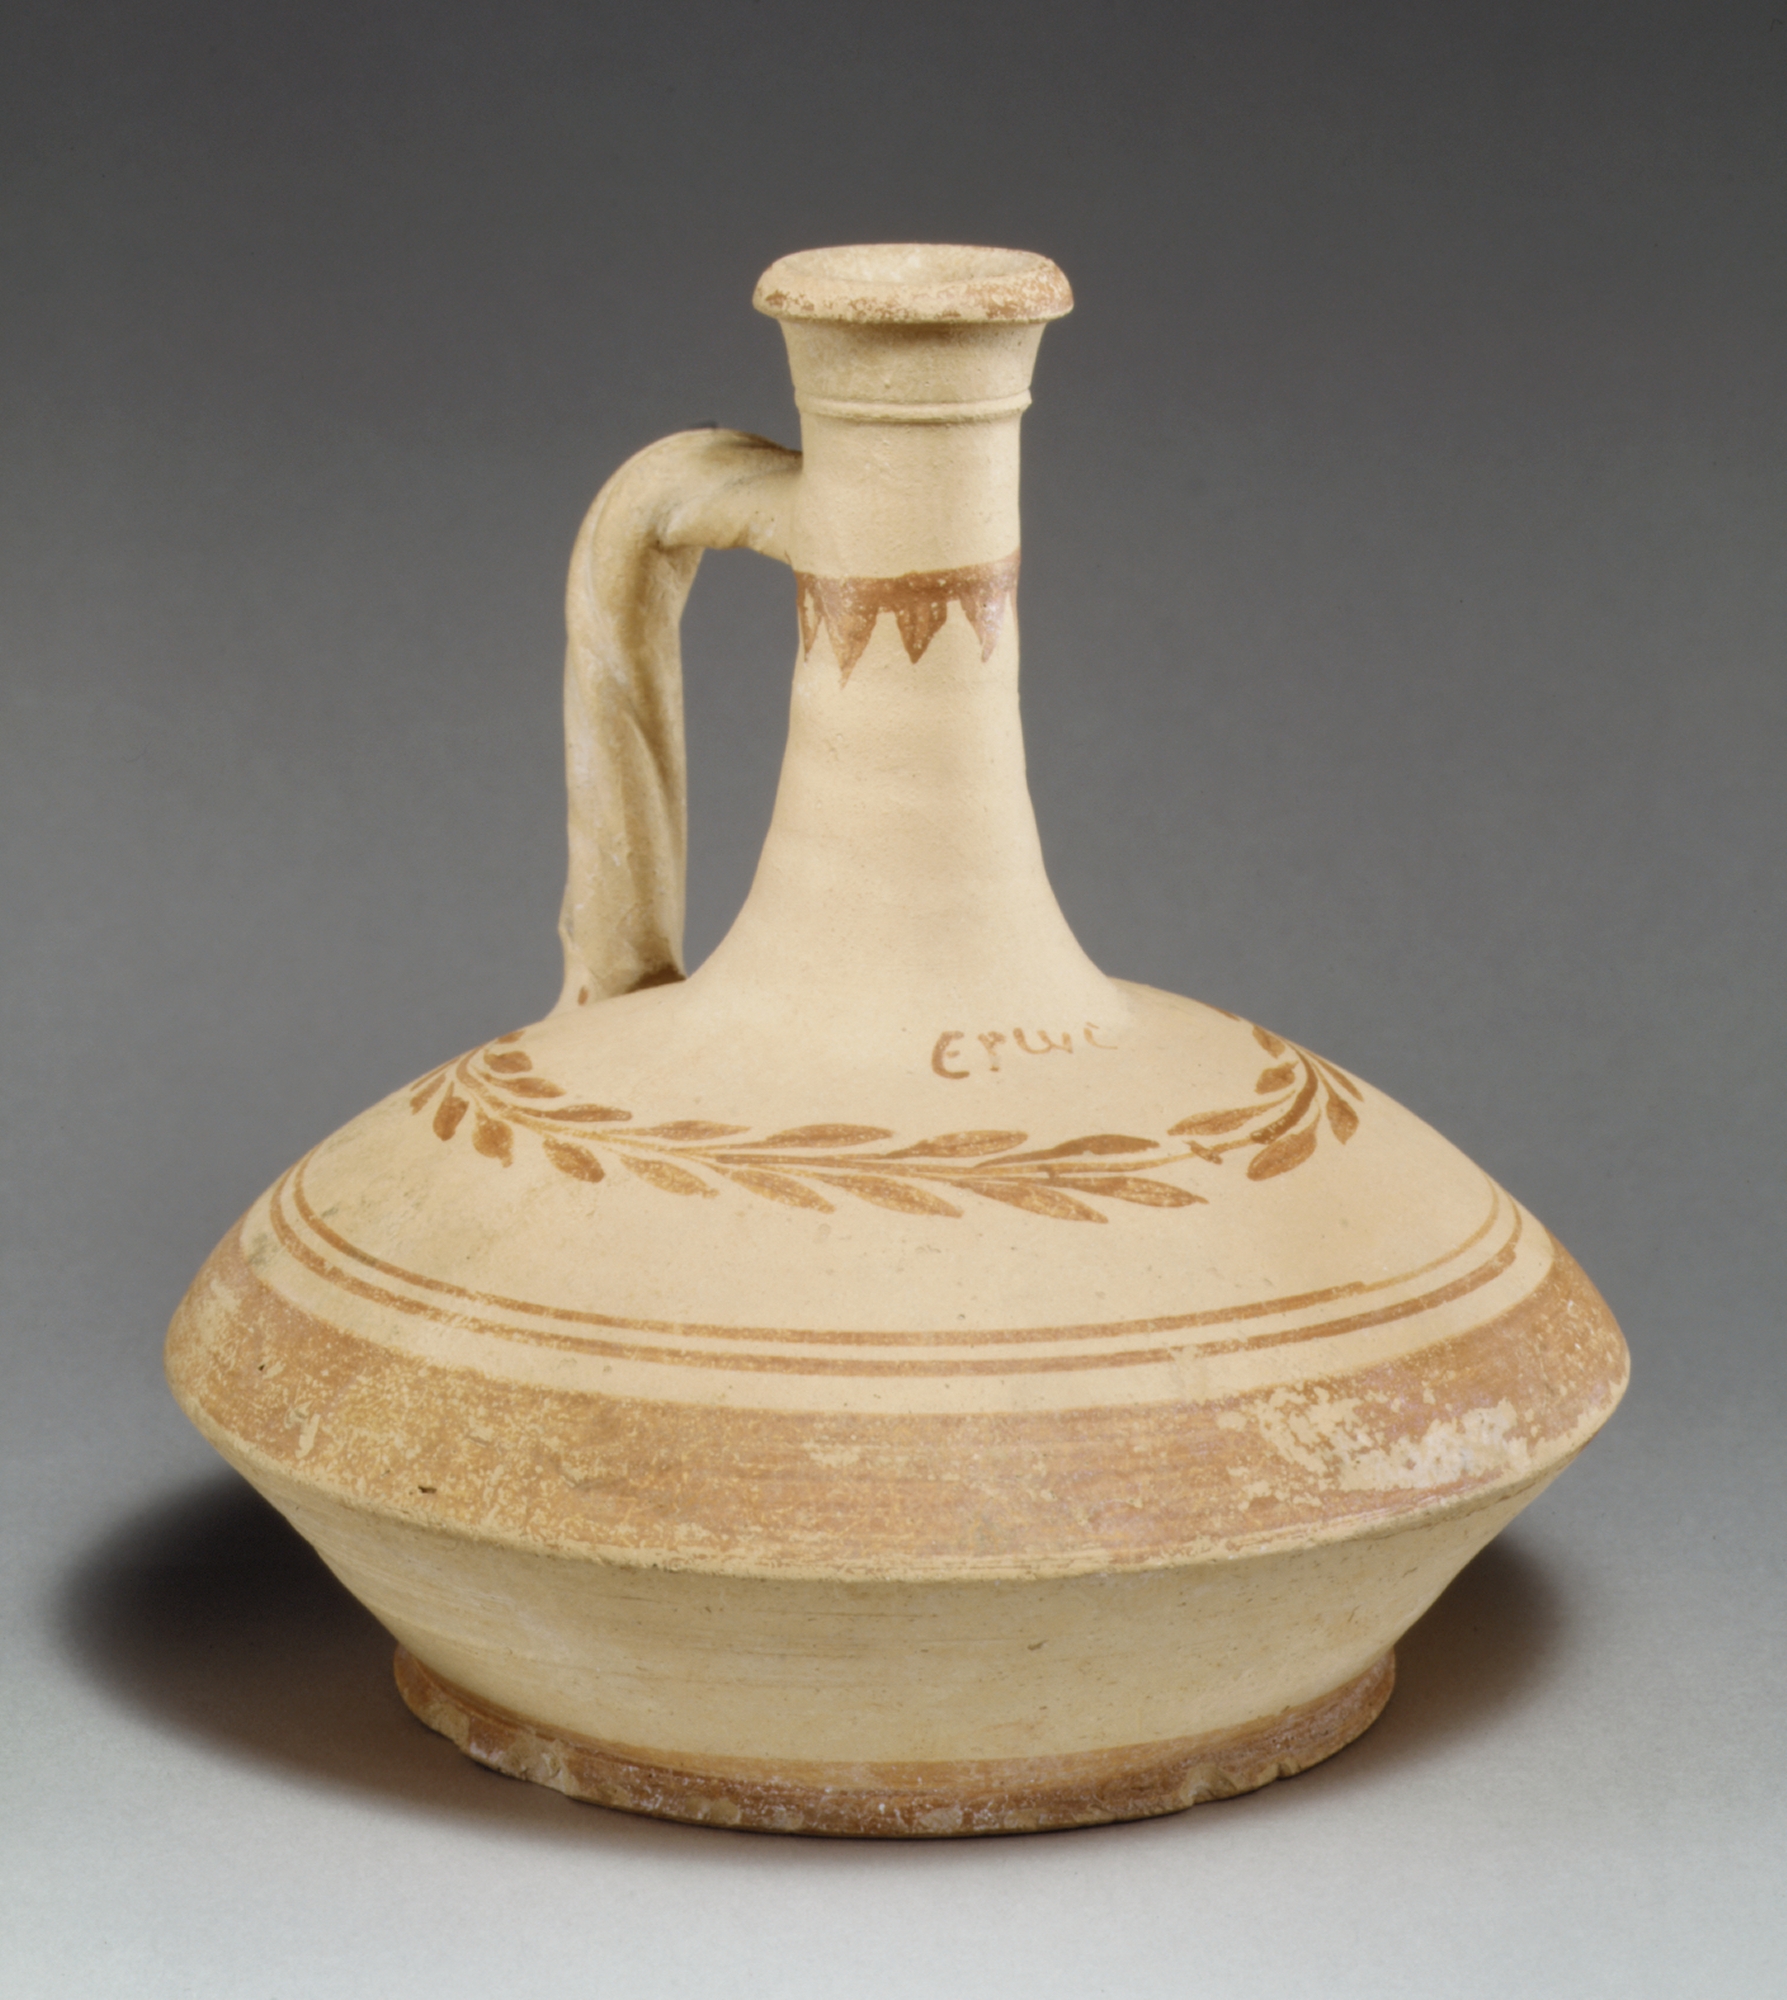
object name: lagynos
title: Terracotta lagynos (pitcher)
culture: cypriot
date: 134-68 BCE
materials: terracotta